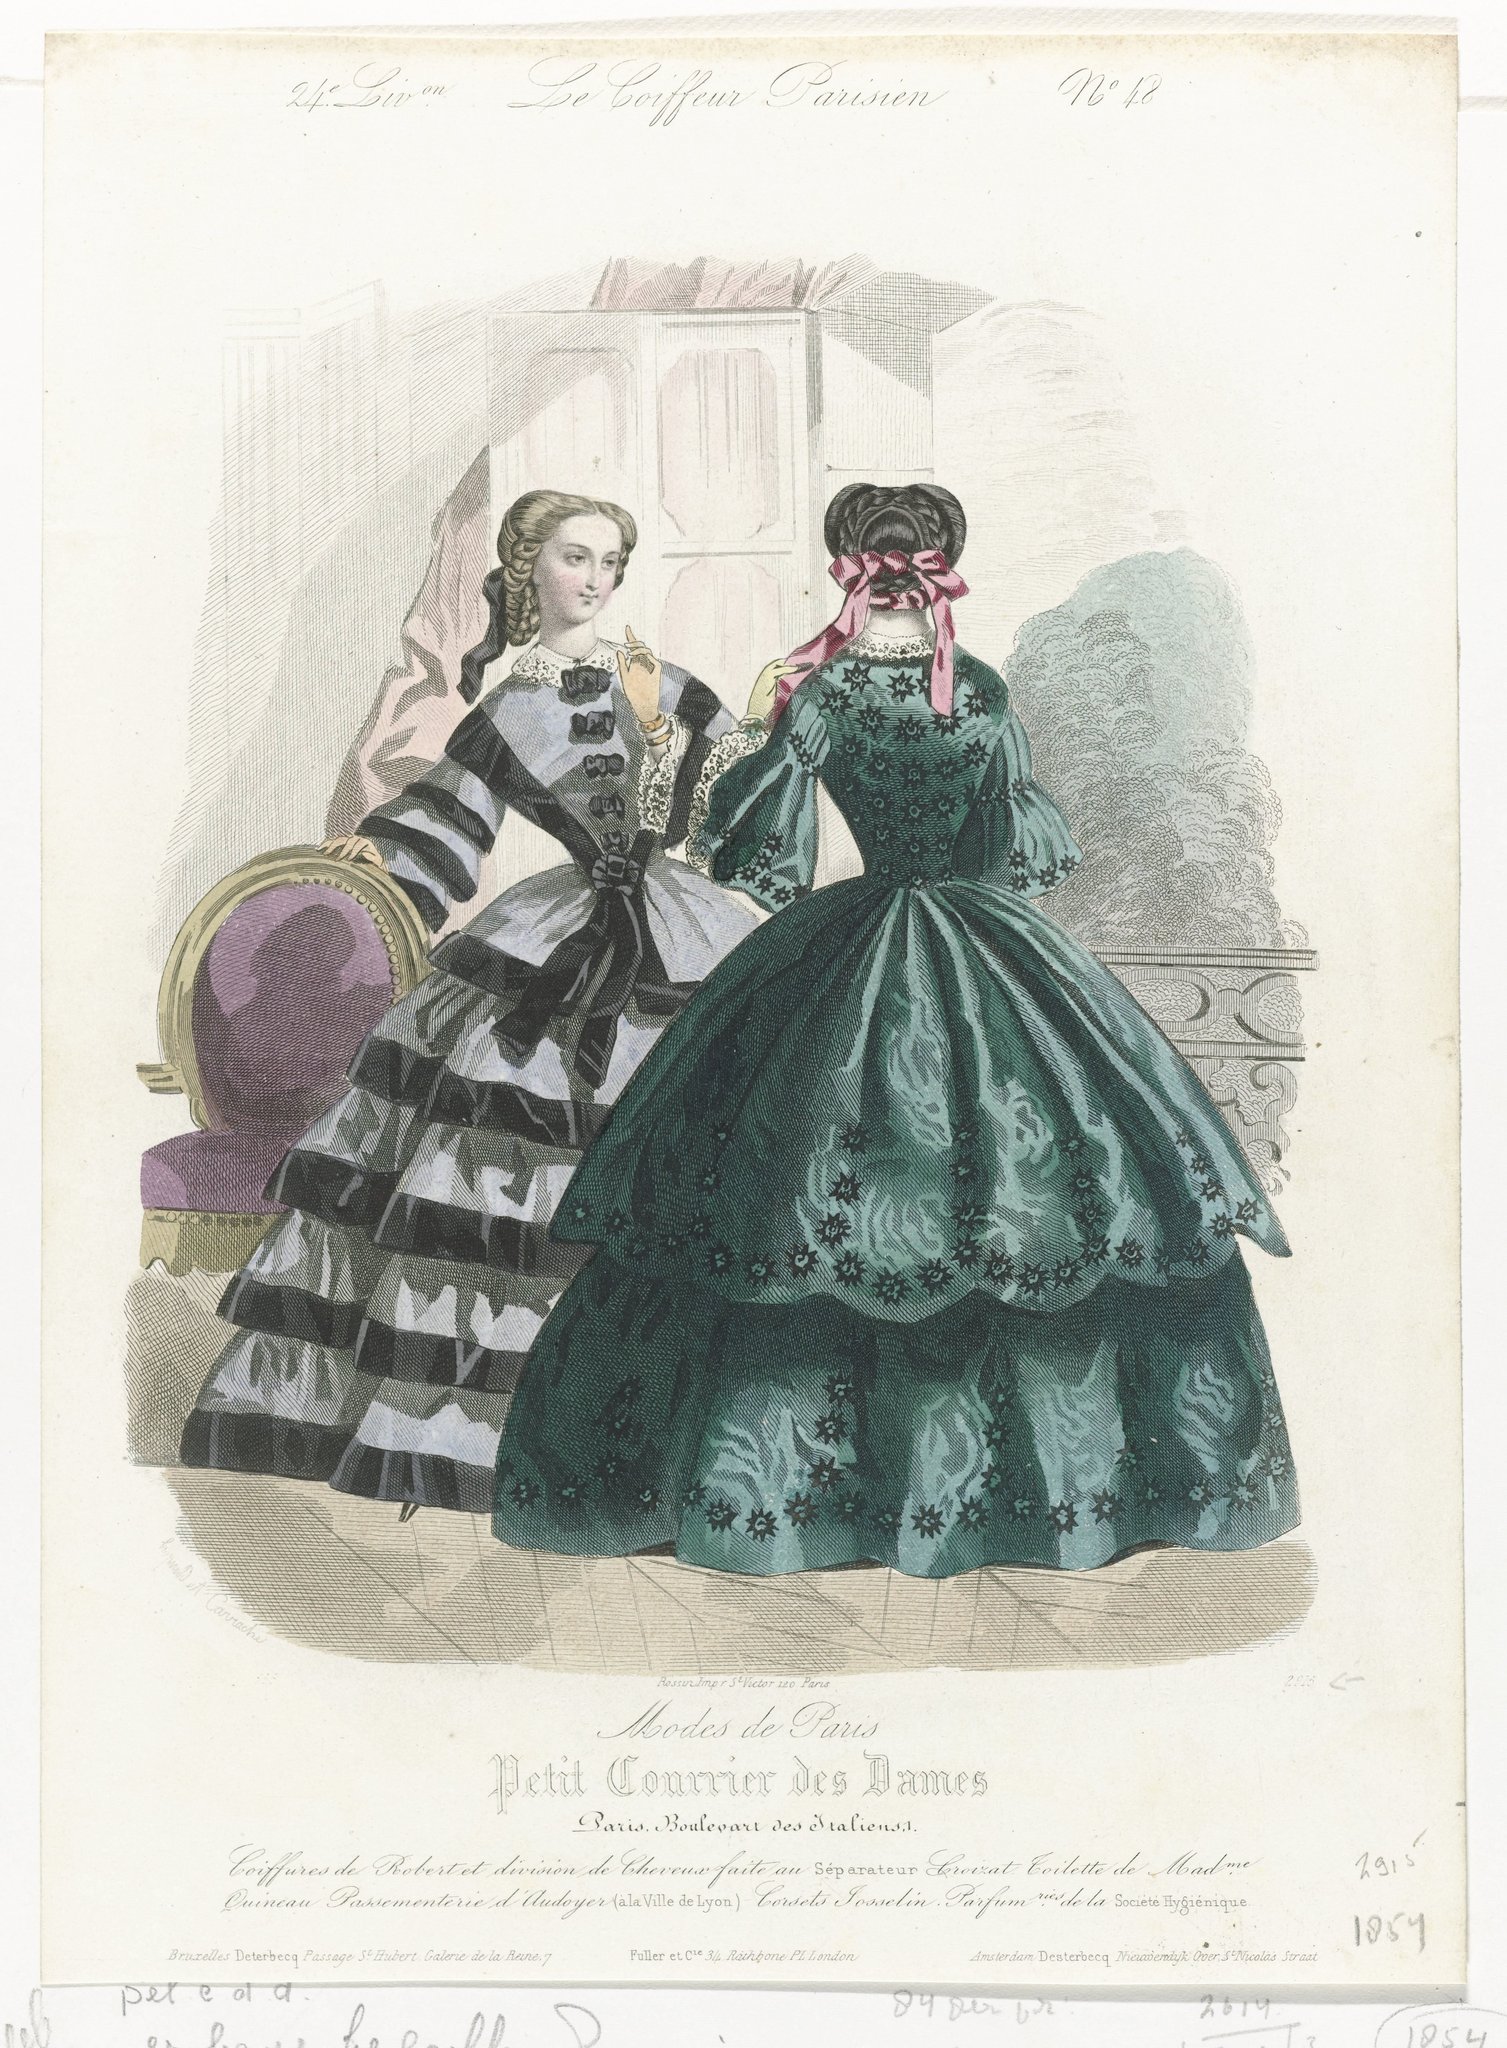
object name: fashion print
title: Petit Courrier des Dames, 1854, No. 2915, Le Coiffeur Parisien, 24e Liv.on, No. 48 : Coiffures (...)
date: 1854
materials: paper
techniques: engraving, hand coloring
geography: london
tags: ornamental parts of clothing (+ women's clothes), styles of hairdress - aa - ~ women, fashion plates, gloves, mittens, etc. (+ women's clothes), neck-gear ~ clothing (+ women's clothes), bracelet, wristlet (+ women's clothes)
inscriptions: title: ‘Modes de Paris / Petit Courrier des Dames’, address: ‘Paris, Boulevart des Italiens, 1. / Bruxelles Deterbecq Passage St. Hubert Galerie de la Reine, 7 / Fuller et Cie, 34 Rathbone Pl. London / Amsterdam Desterbecq Nieuwendijk Over St Nicolas Straat’, title: ‘24e Liv. on Le Coiffeur Parisien No. 48’, caption: ‘Coiffures de Robert et division de Cheveux faite au Séparateur Croizat Toilette de Mad.me Quineau Passementerie d'Audoyer (à la Ville de Lyon) Corsets Josselin. Parfum.ries de la Société Hygiénique.’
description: Twee vrouwen in een interieur. Onder de voorstelling enkele regels reclametekst voor verschillende producten. Prent uit het modetijdschrift Petit Courrier des Dames (1821-1868).